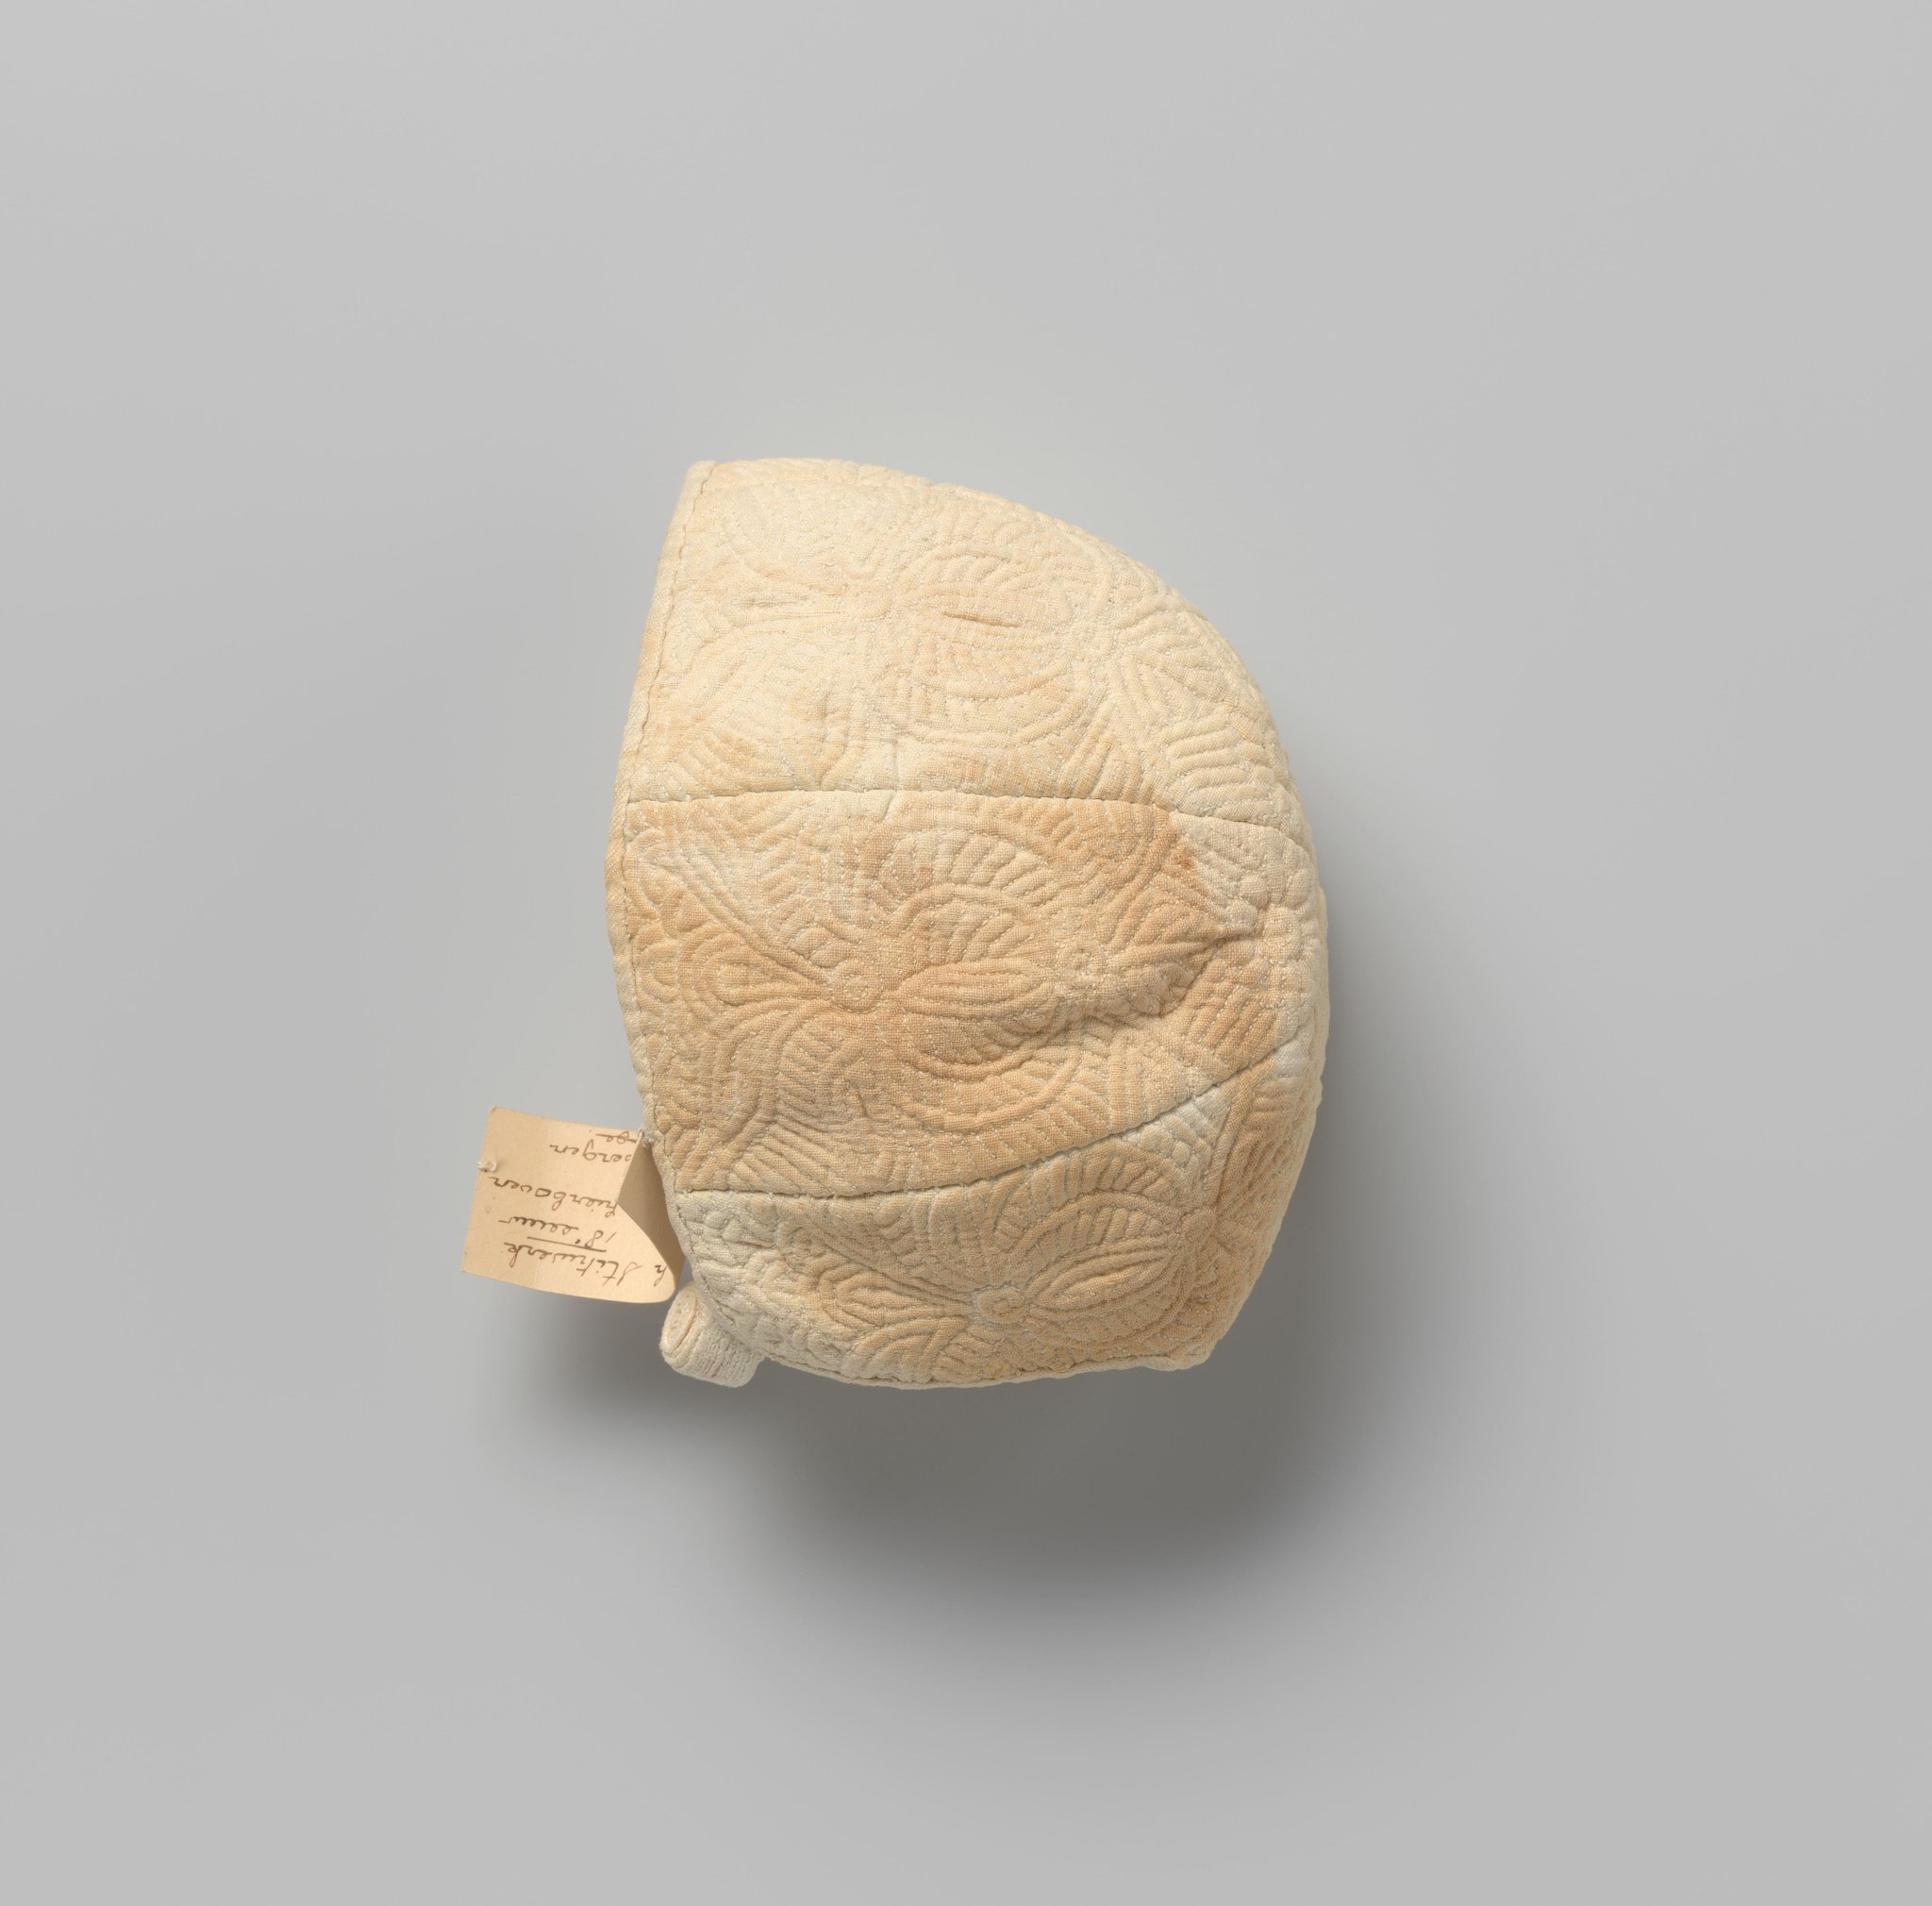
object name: hoofddeksel, hoofdbedekking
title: Katoenen muts met Zaans stikwerk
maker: Anonymous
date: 1700-1800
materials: cotton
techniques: embroidered, quilting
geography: netherlands